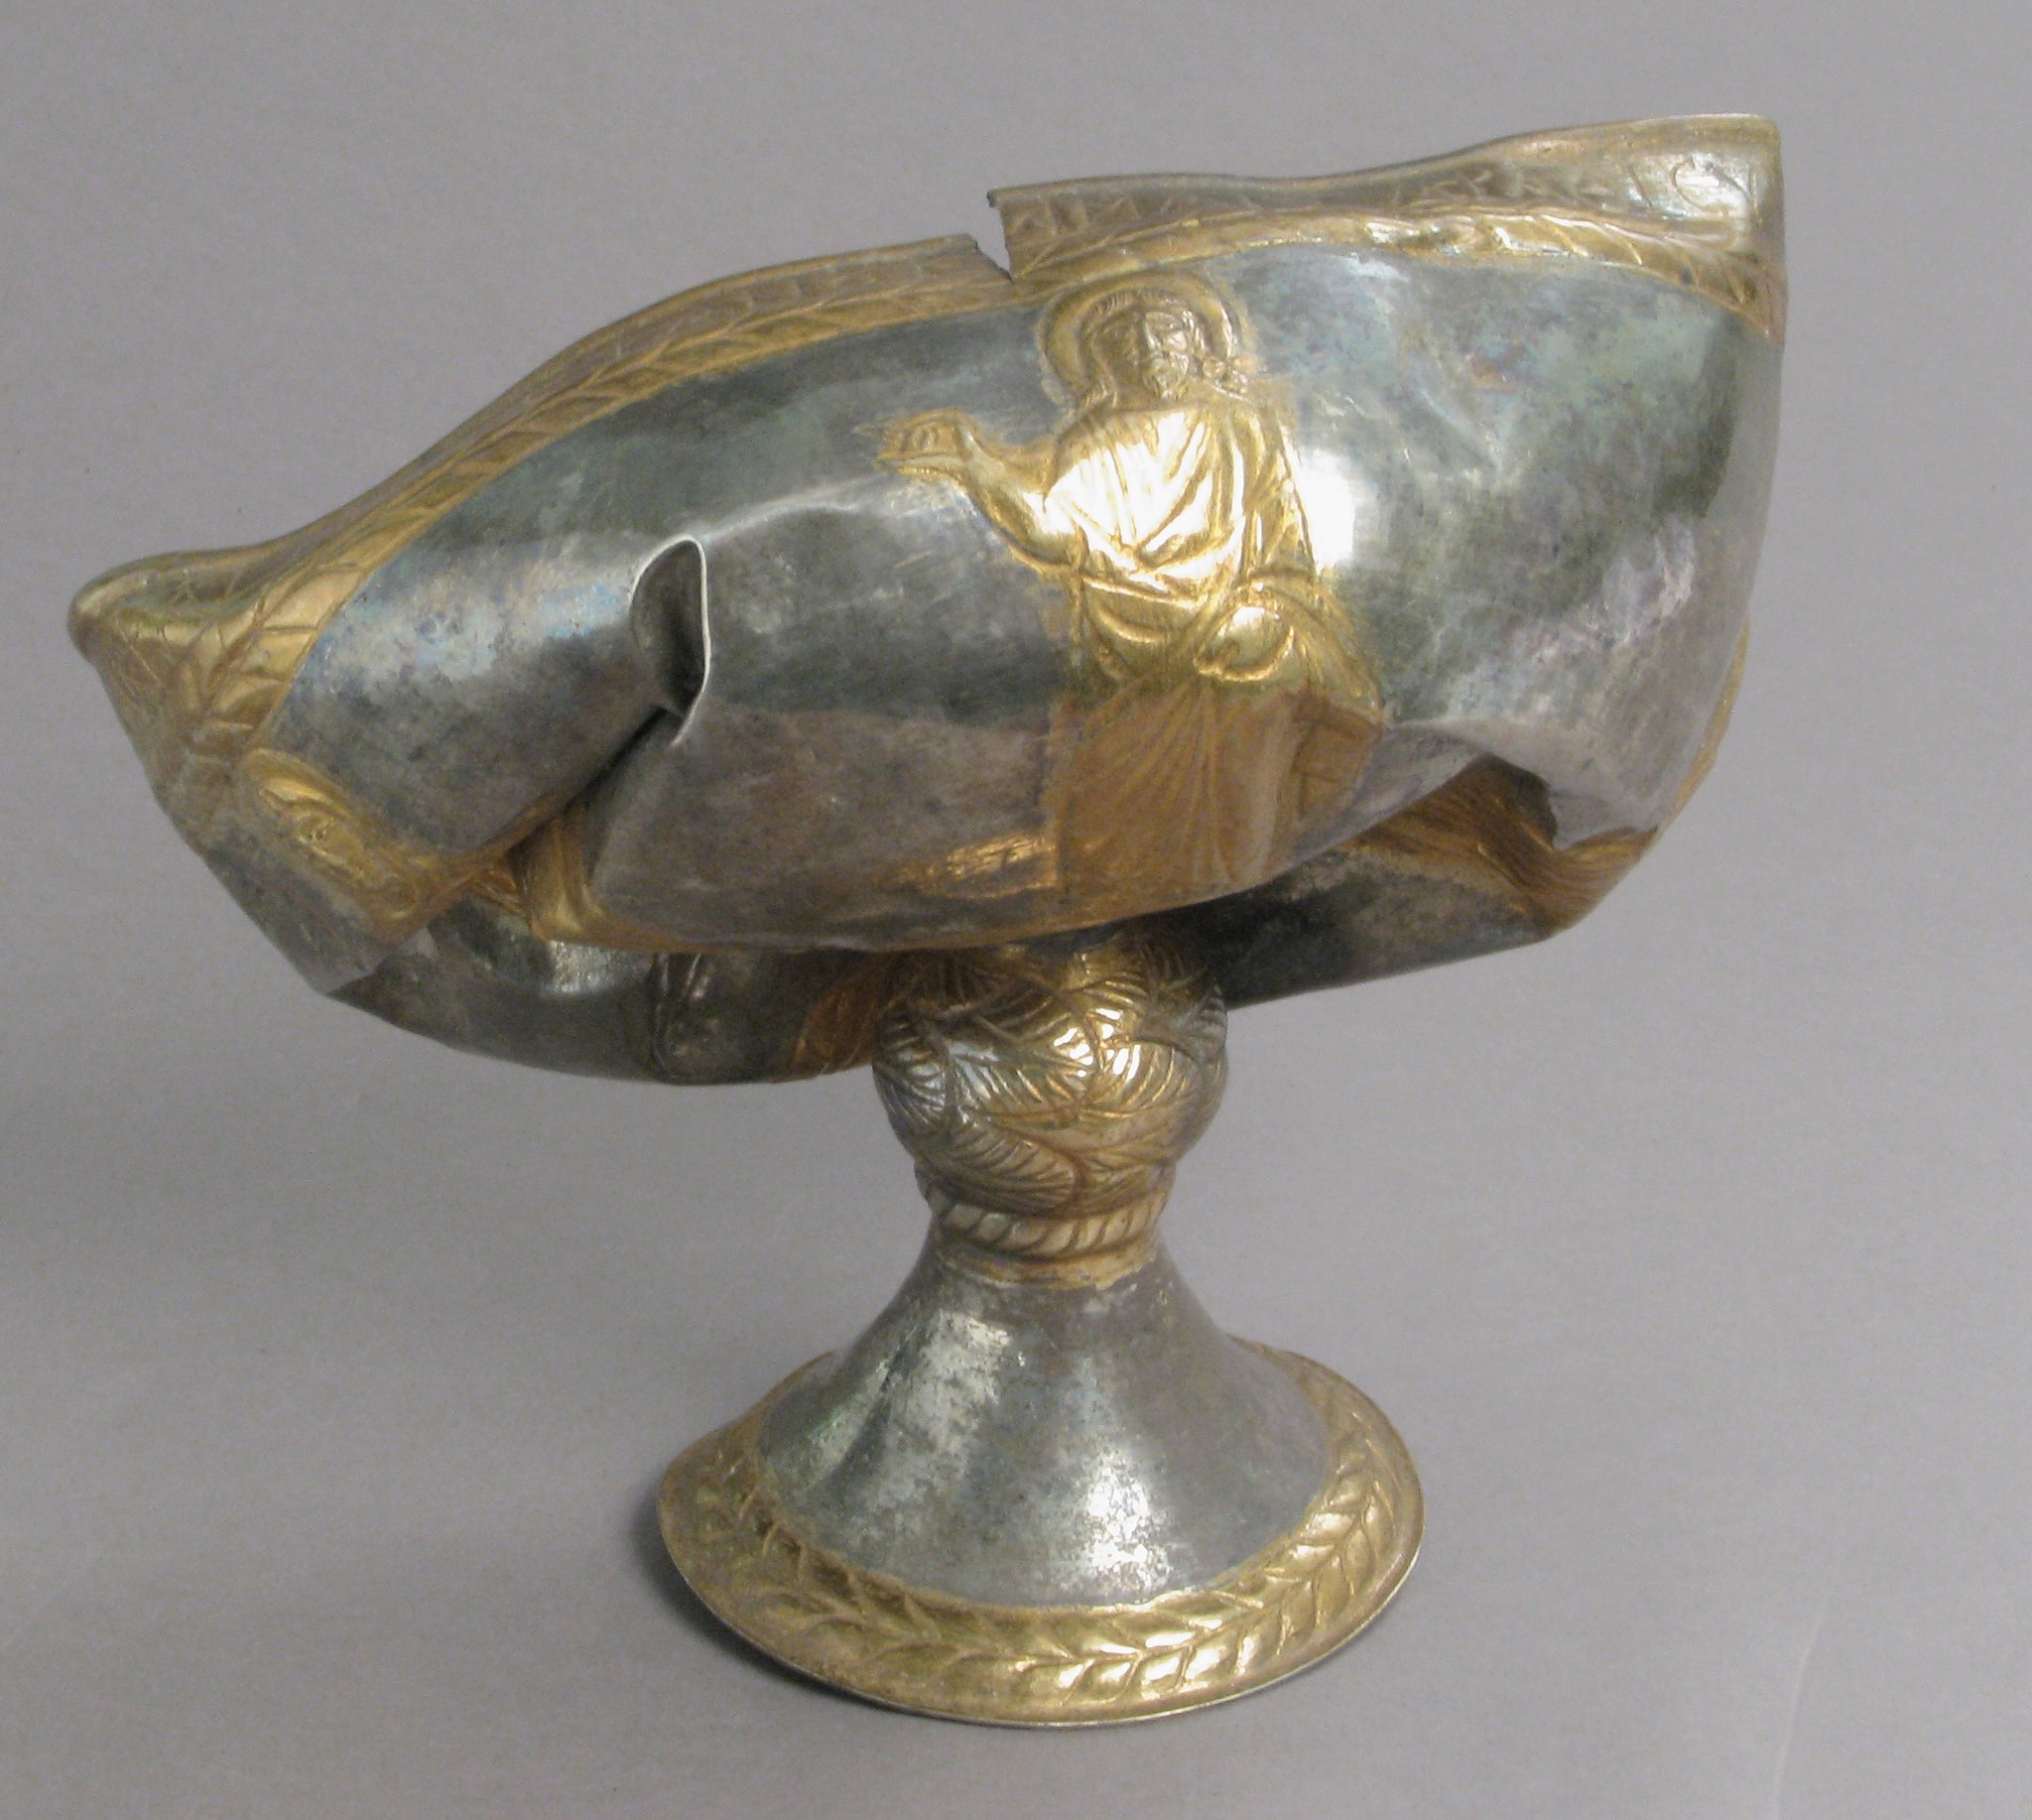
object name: chalice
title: The Attarouthi Treasure - Chalice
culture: byzantine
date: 500-650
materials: gilt silver, silver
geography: syria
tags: christ